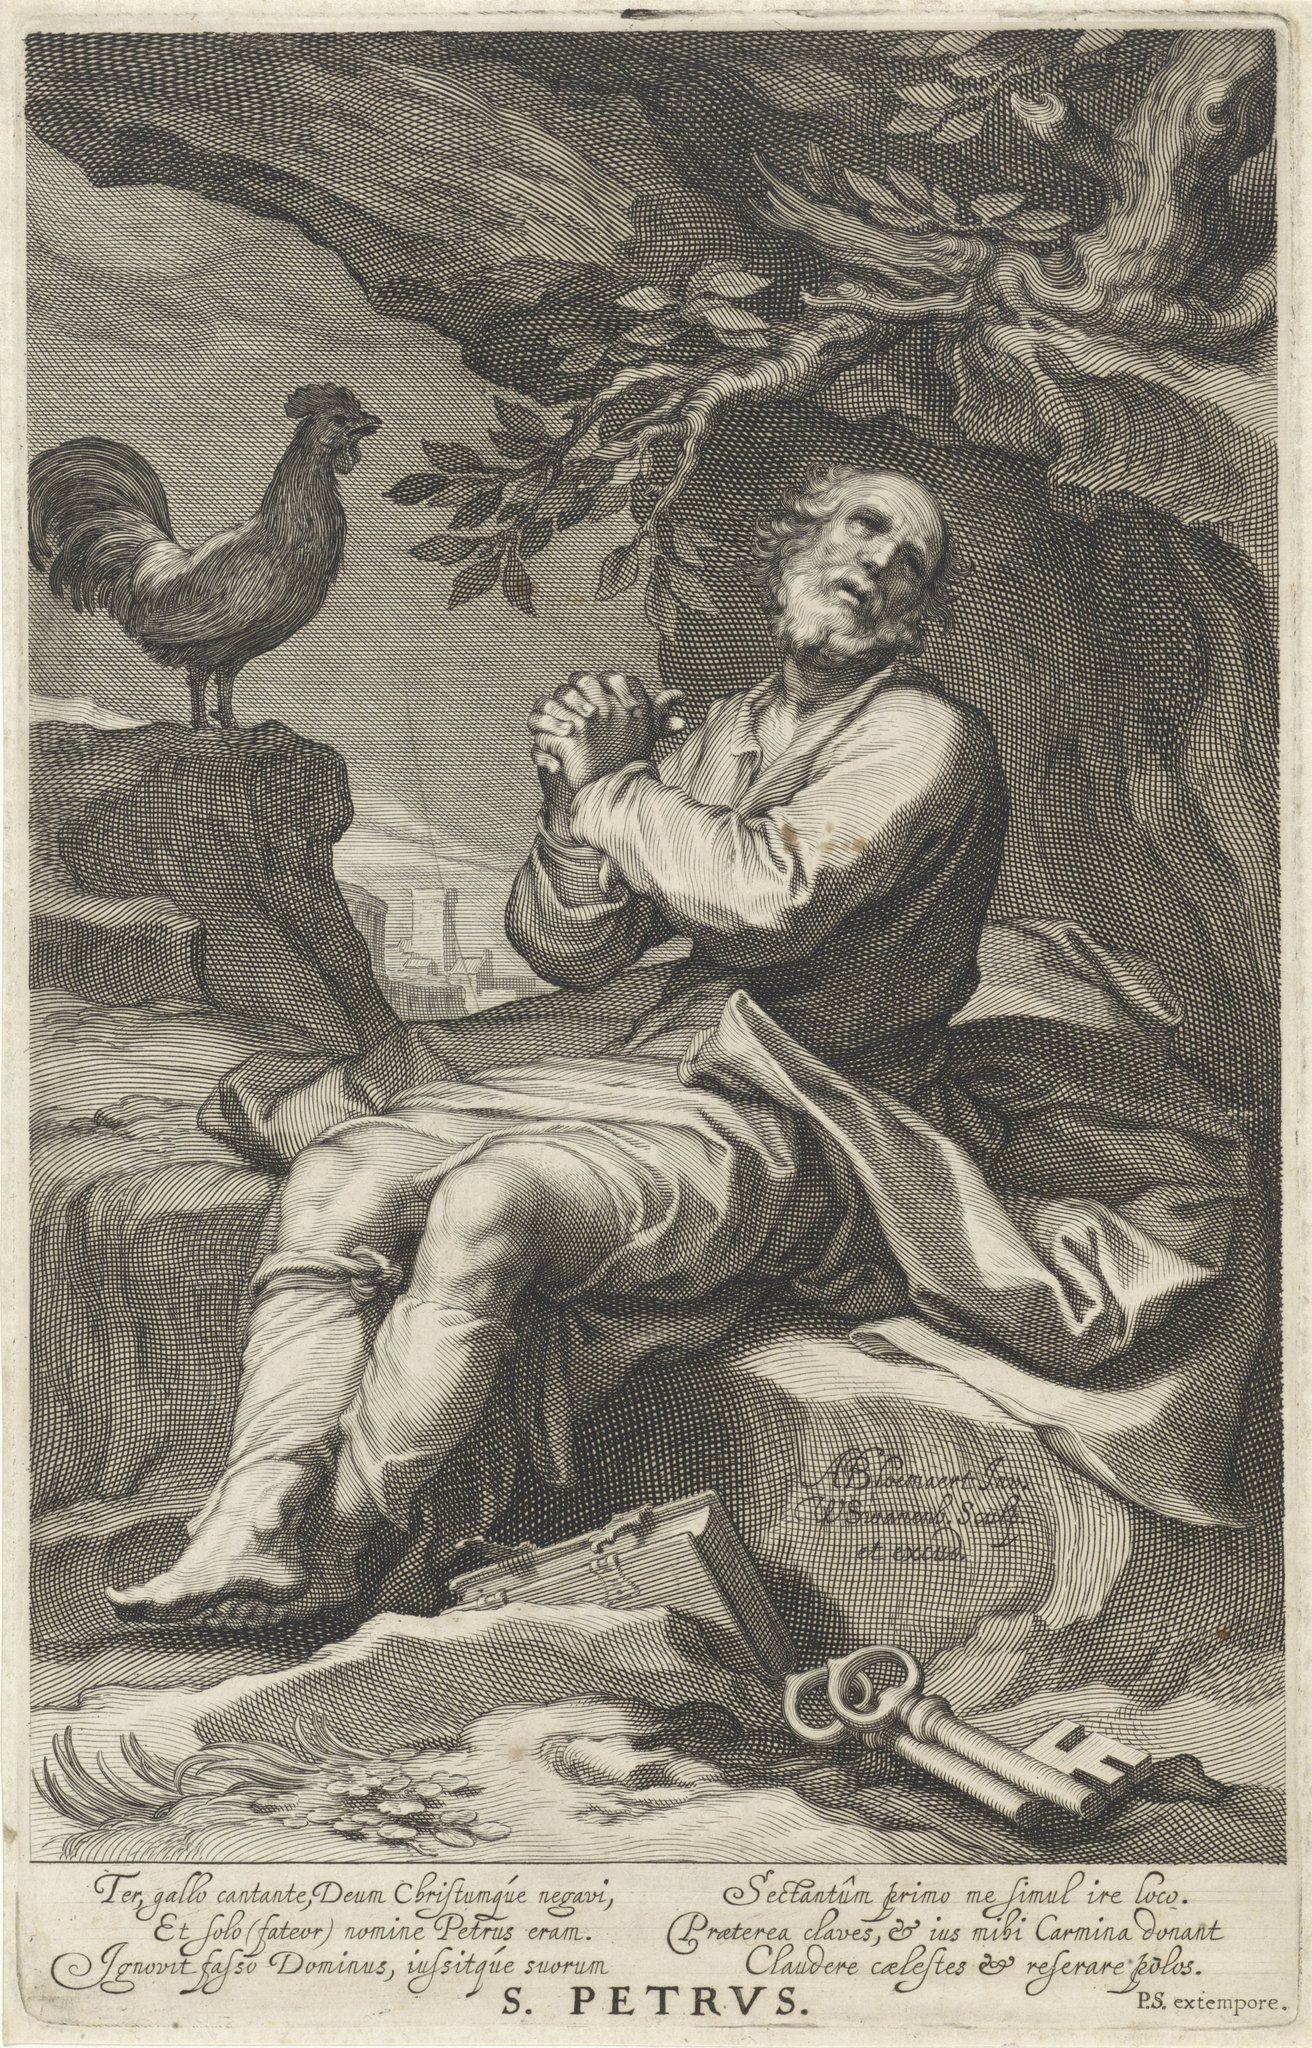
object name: print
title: S. Petrus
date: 1609-1611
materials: paper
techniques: engraving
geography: leiden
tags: landscapes, the apostle peter, first bishop of rome; possible attributes: book, cock, (upturned) cross, (triple) crozier, fish, key, scroll, ship, tiara - portrait of male saint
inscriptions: collector's mark: Lugt 2228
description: Petrus zit met gevouwen handen op een rots onder een boom. Voor hem liggen twee sleutels en een boek, het evangelie. Schuin achter hem staat een haan, die verwijst naar de verloochening van Christus. In de verte staan enkele gebouwen. Onder de voorstelling bevindt zich een zesregelige, Latijnse tekst over de verloochening en een passage over de sleutels.